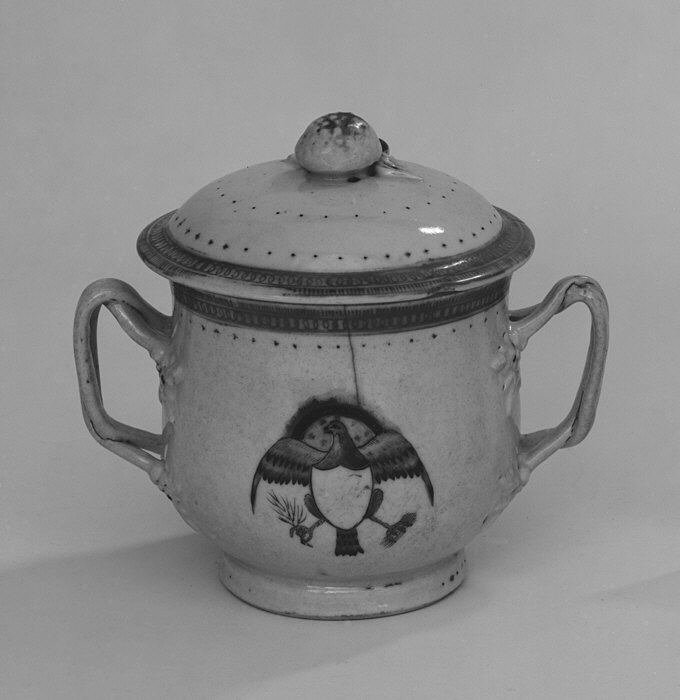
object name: sugar bowl with cover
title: Sugar bowl with cover (part of a service)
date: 1767-1833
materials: hard paste porcelain